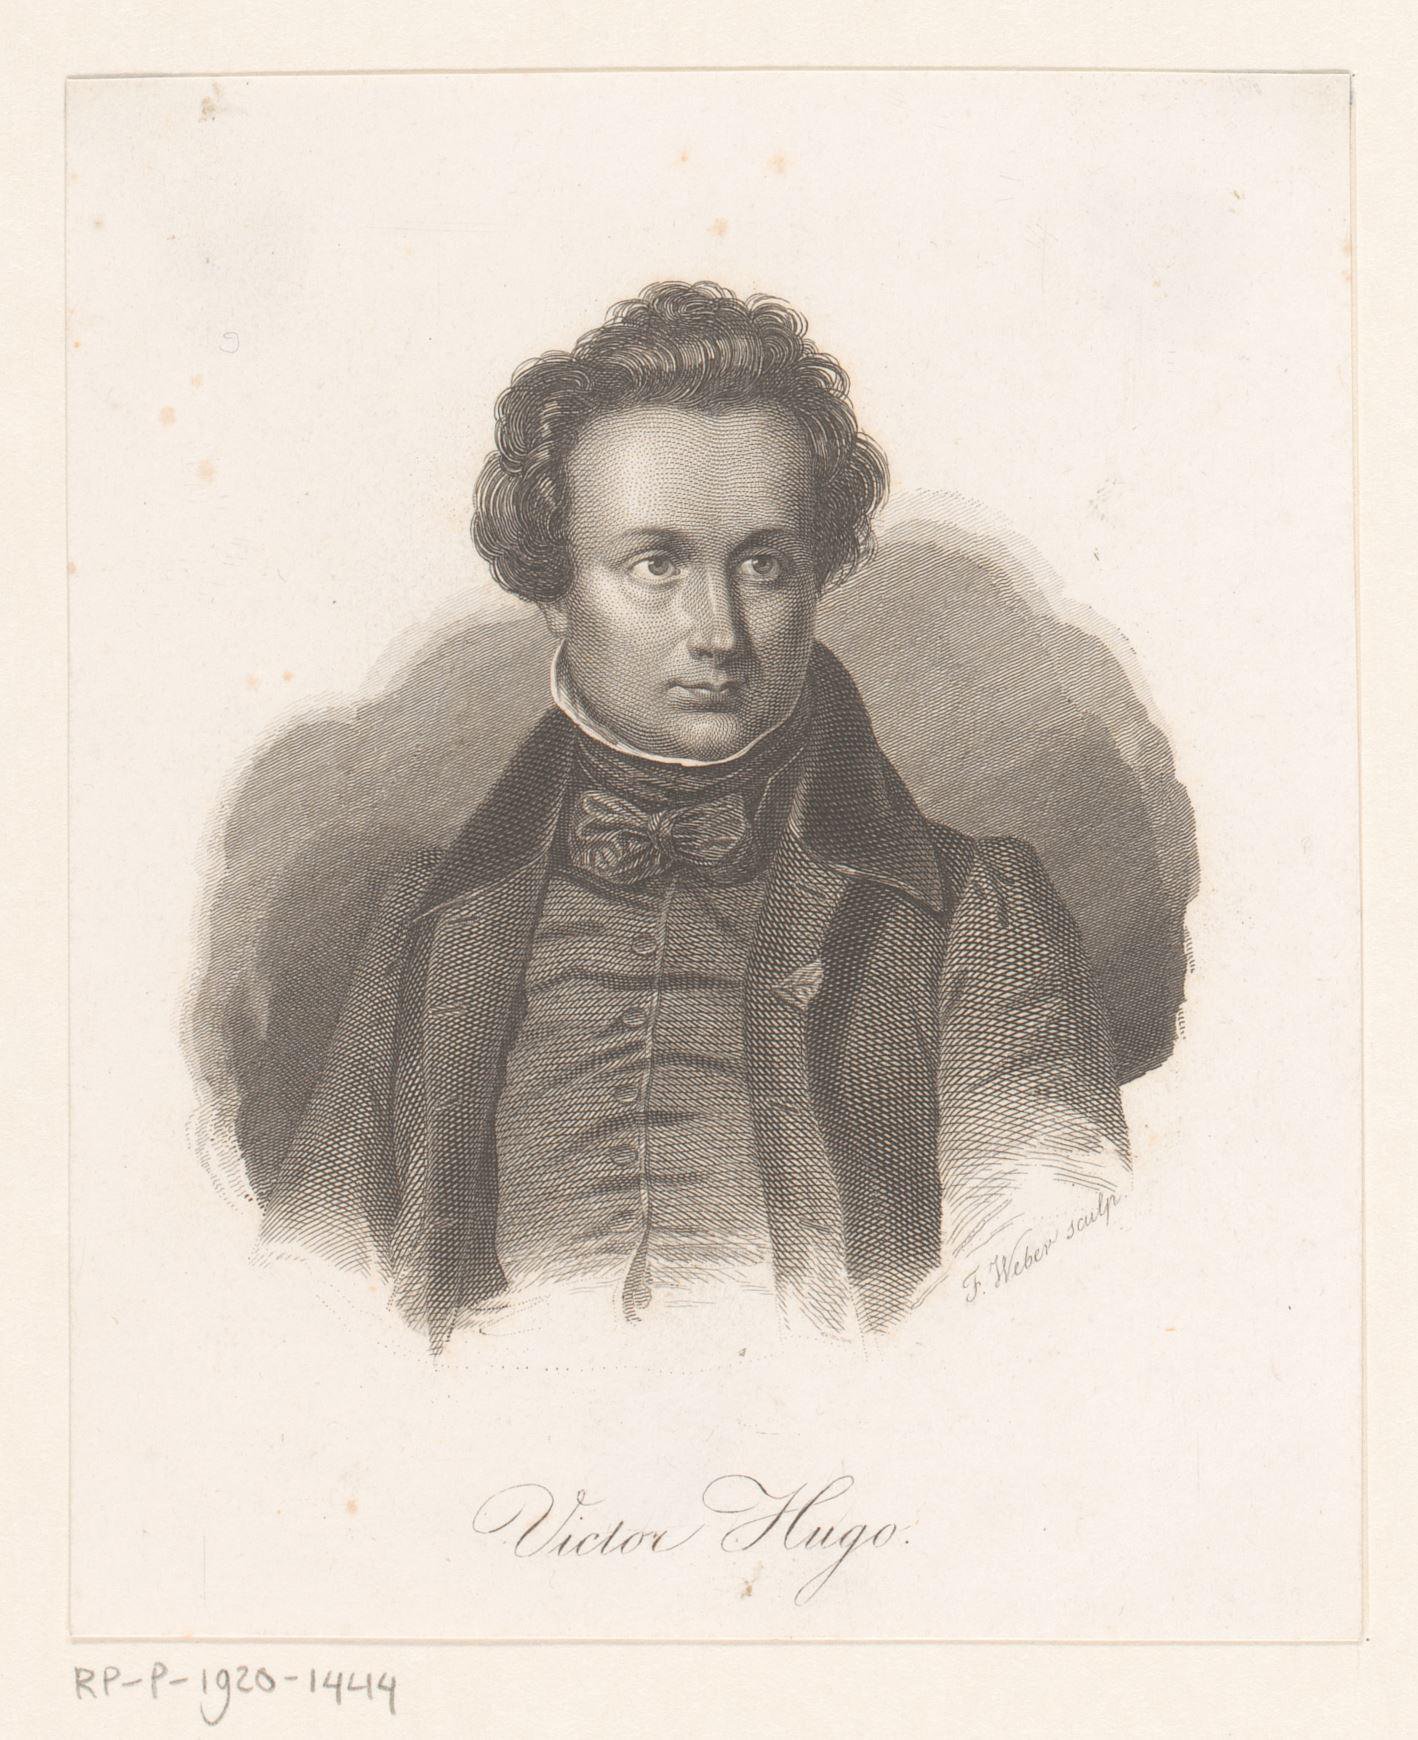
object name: print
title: Portret van Victor Hugo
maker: friedrich weber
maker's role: print maker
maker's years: 1813-1882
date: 1823-1882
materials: paper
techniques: engraving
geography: germany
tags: paris, victor hugo, historical persons, portrait of a writer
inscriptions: collector's mark: Lugt 2228